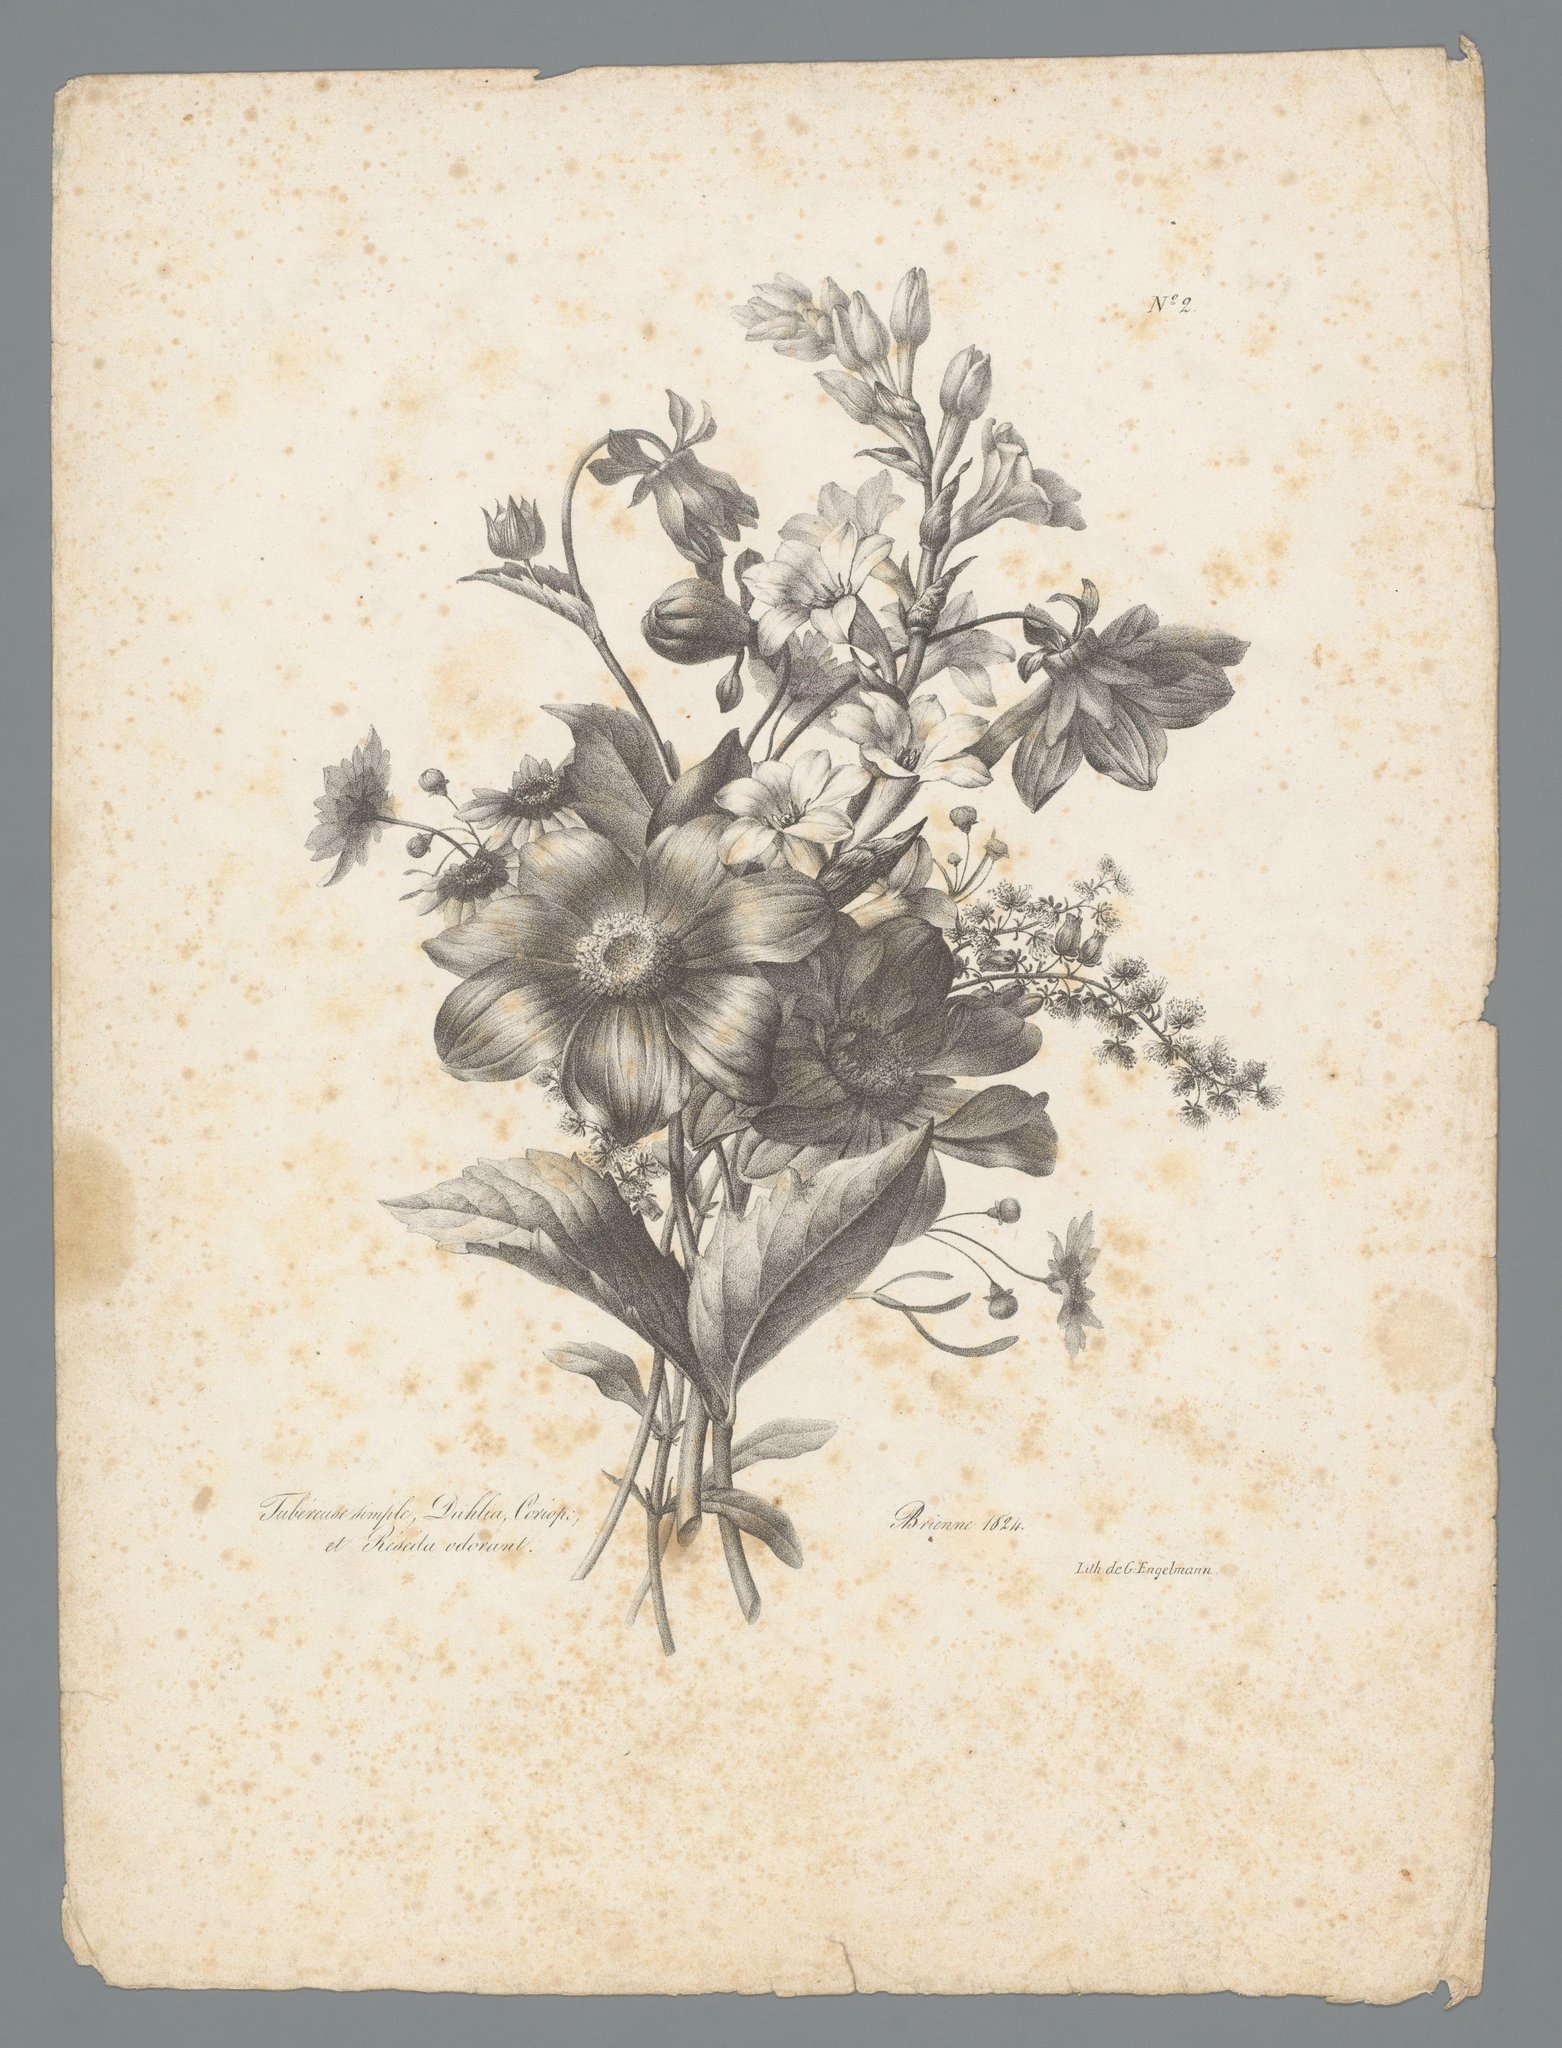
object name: print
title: Bloemboeketten door Auguste Piquet de Brienne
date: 1824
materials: paper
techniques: lithograph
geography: paris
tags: cut flowers; nosegay, bunch of flowers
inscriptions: collector's mark: Lugt 2233